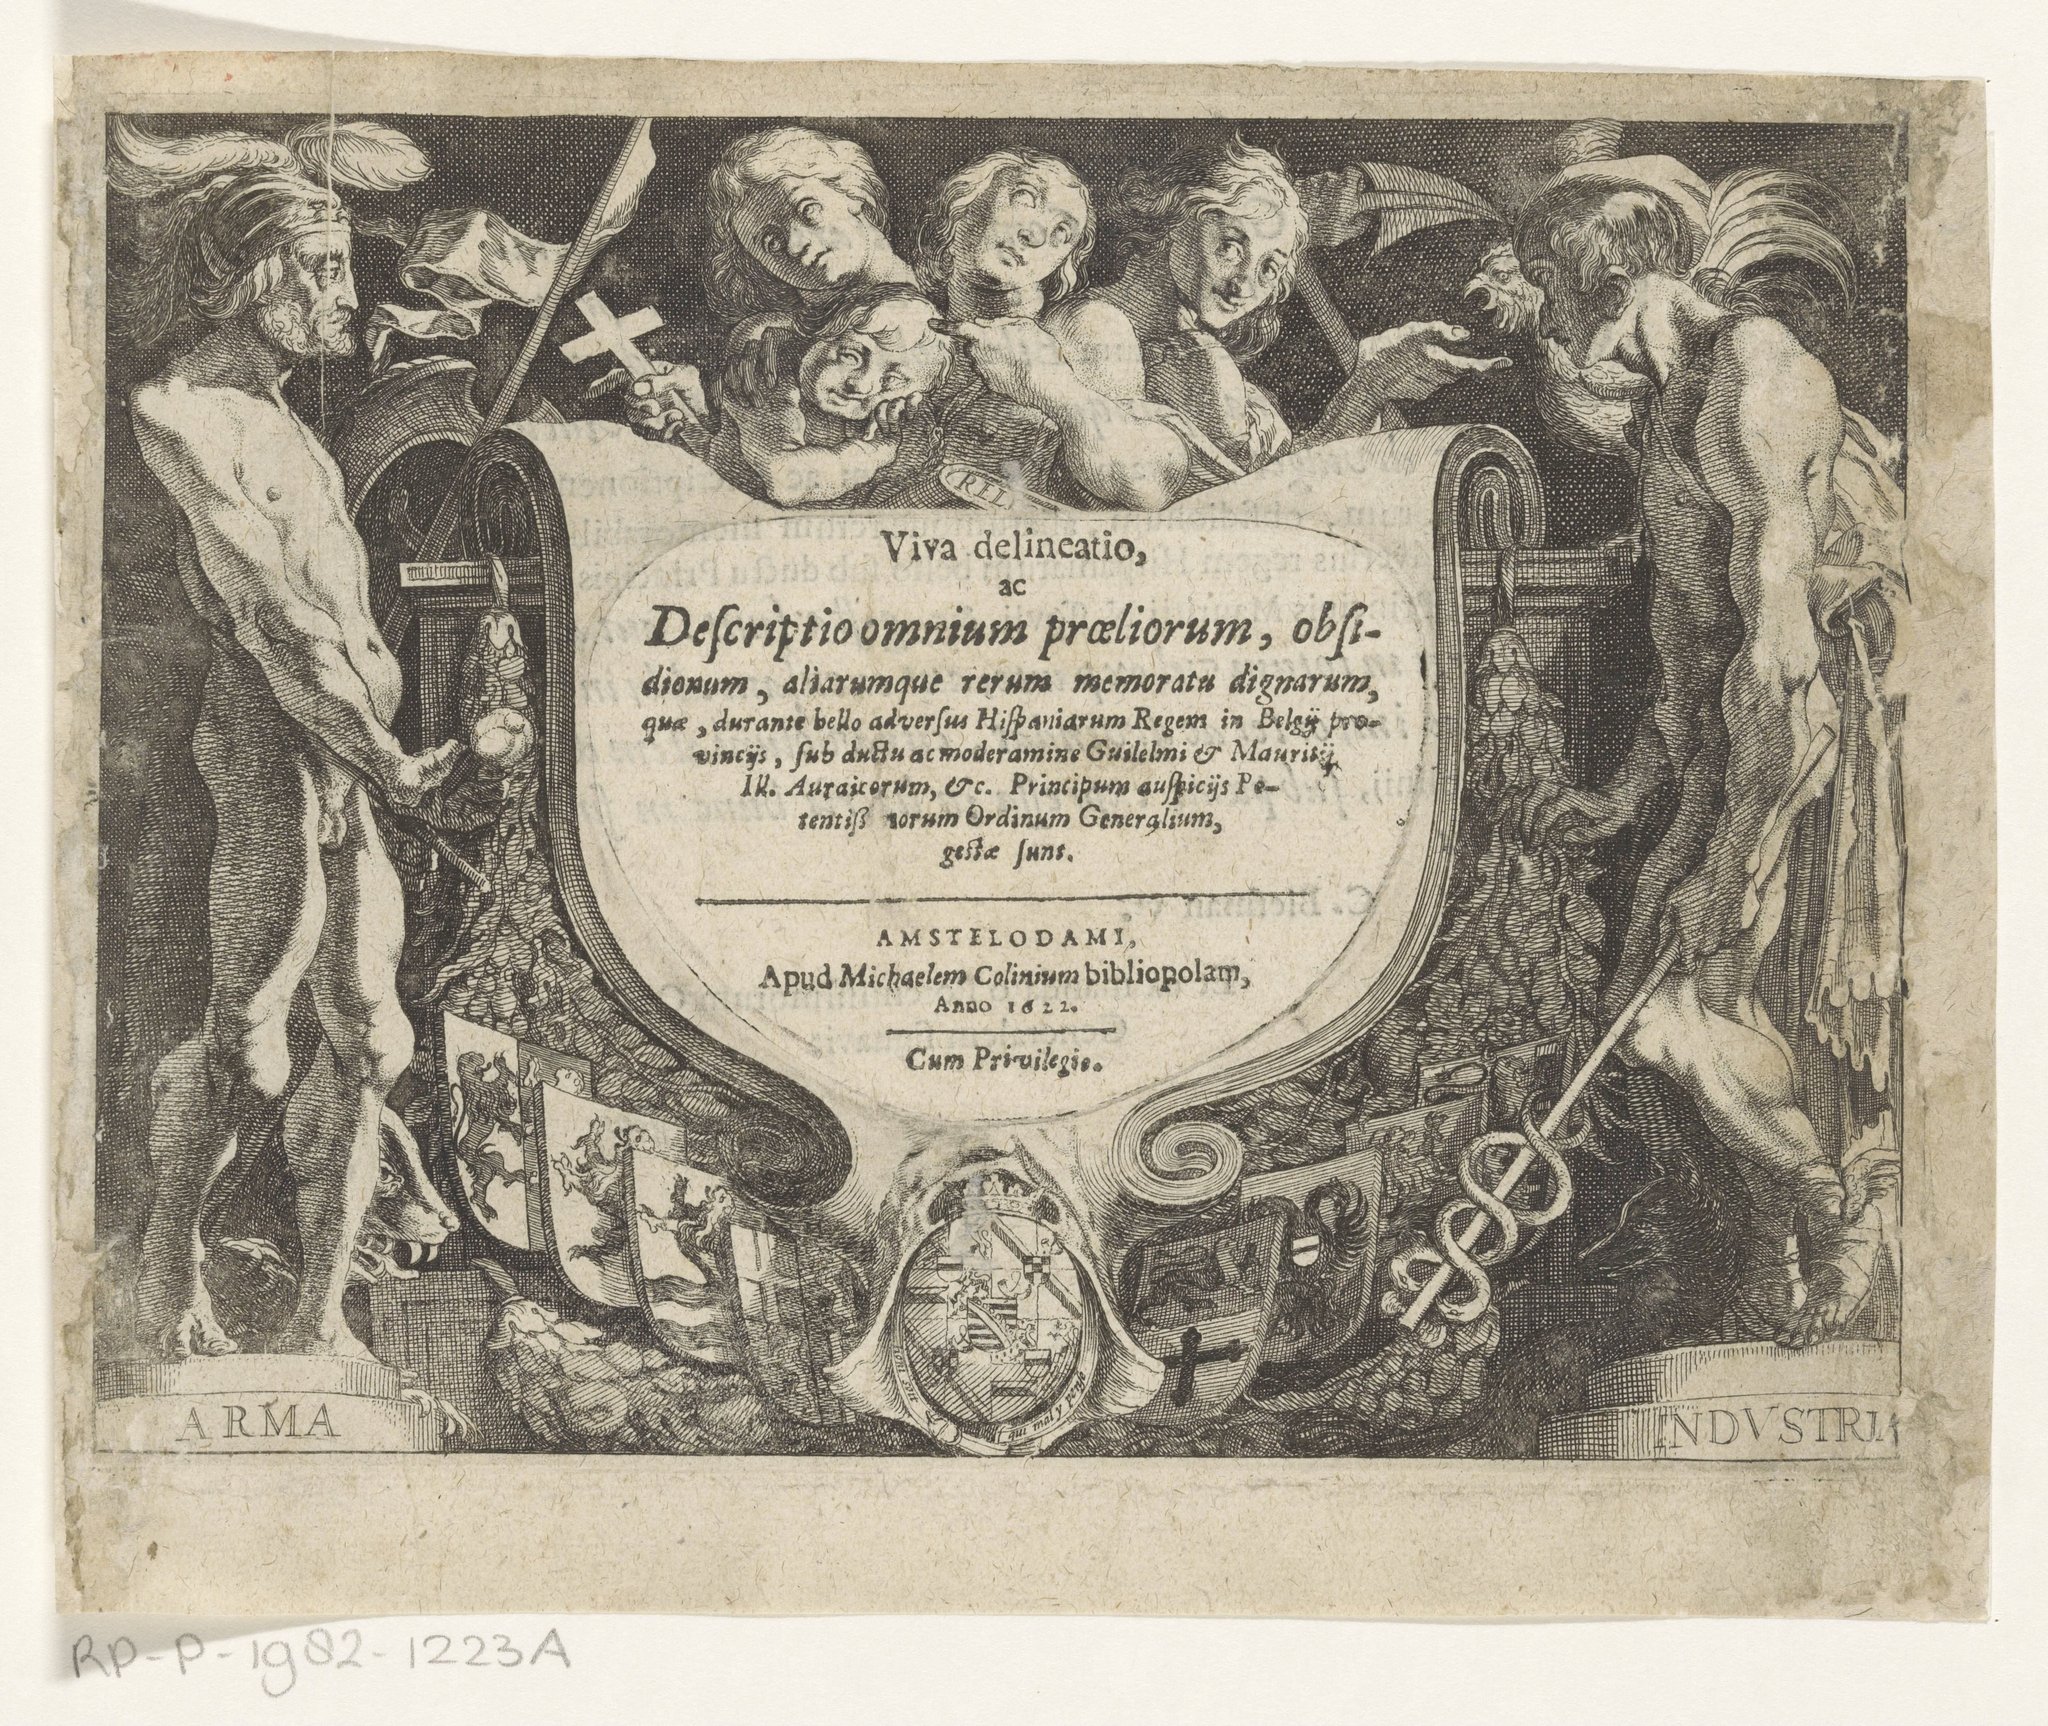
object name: titelblad, titelpagina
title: Allegorische voorstelling met Mars en Mercurius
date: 1622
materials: paper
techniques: etching, letterpress printing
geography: amsterdam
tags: (story of) mars (ares), (story of) mercury (hermes), the three theological virtues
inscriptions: collector's mark: Lugt 2760, collector's mark: Lugt 2228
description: In het midden een cartouche met titel, geflankeerd door Mars (Arma) en Mercurius (Industria). Daarachter de vrouwelijke personificaties van de deugden Geloof, Liefde en Hoop. Onderaan het wapen van prins Maurits en acht provinciewapens. Bedrukt op achterzijde met tekst in het Latijn.